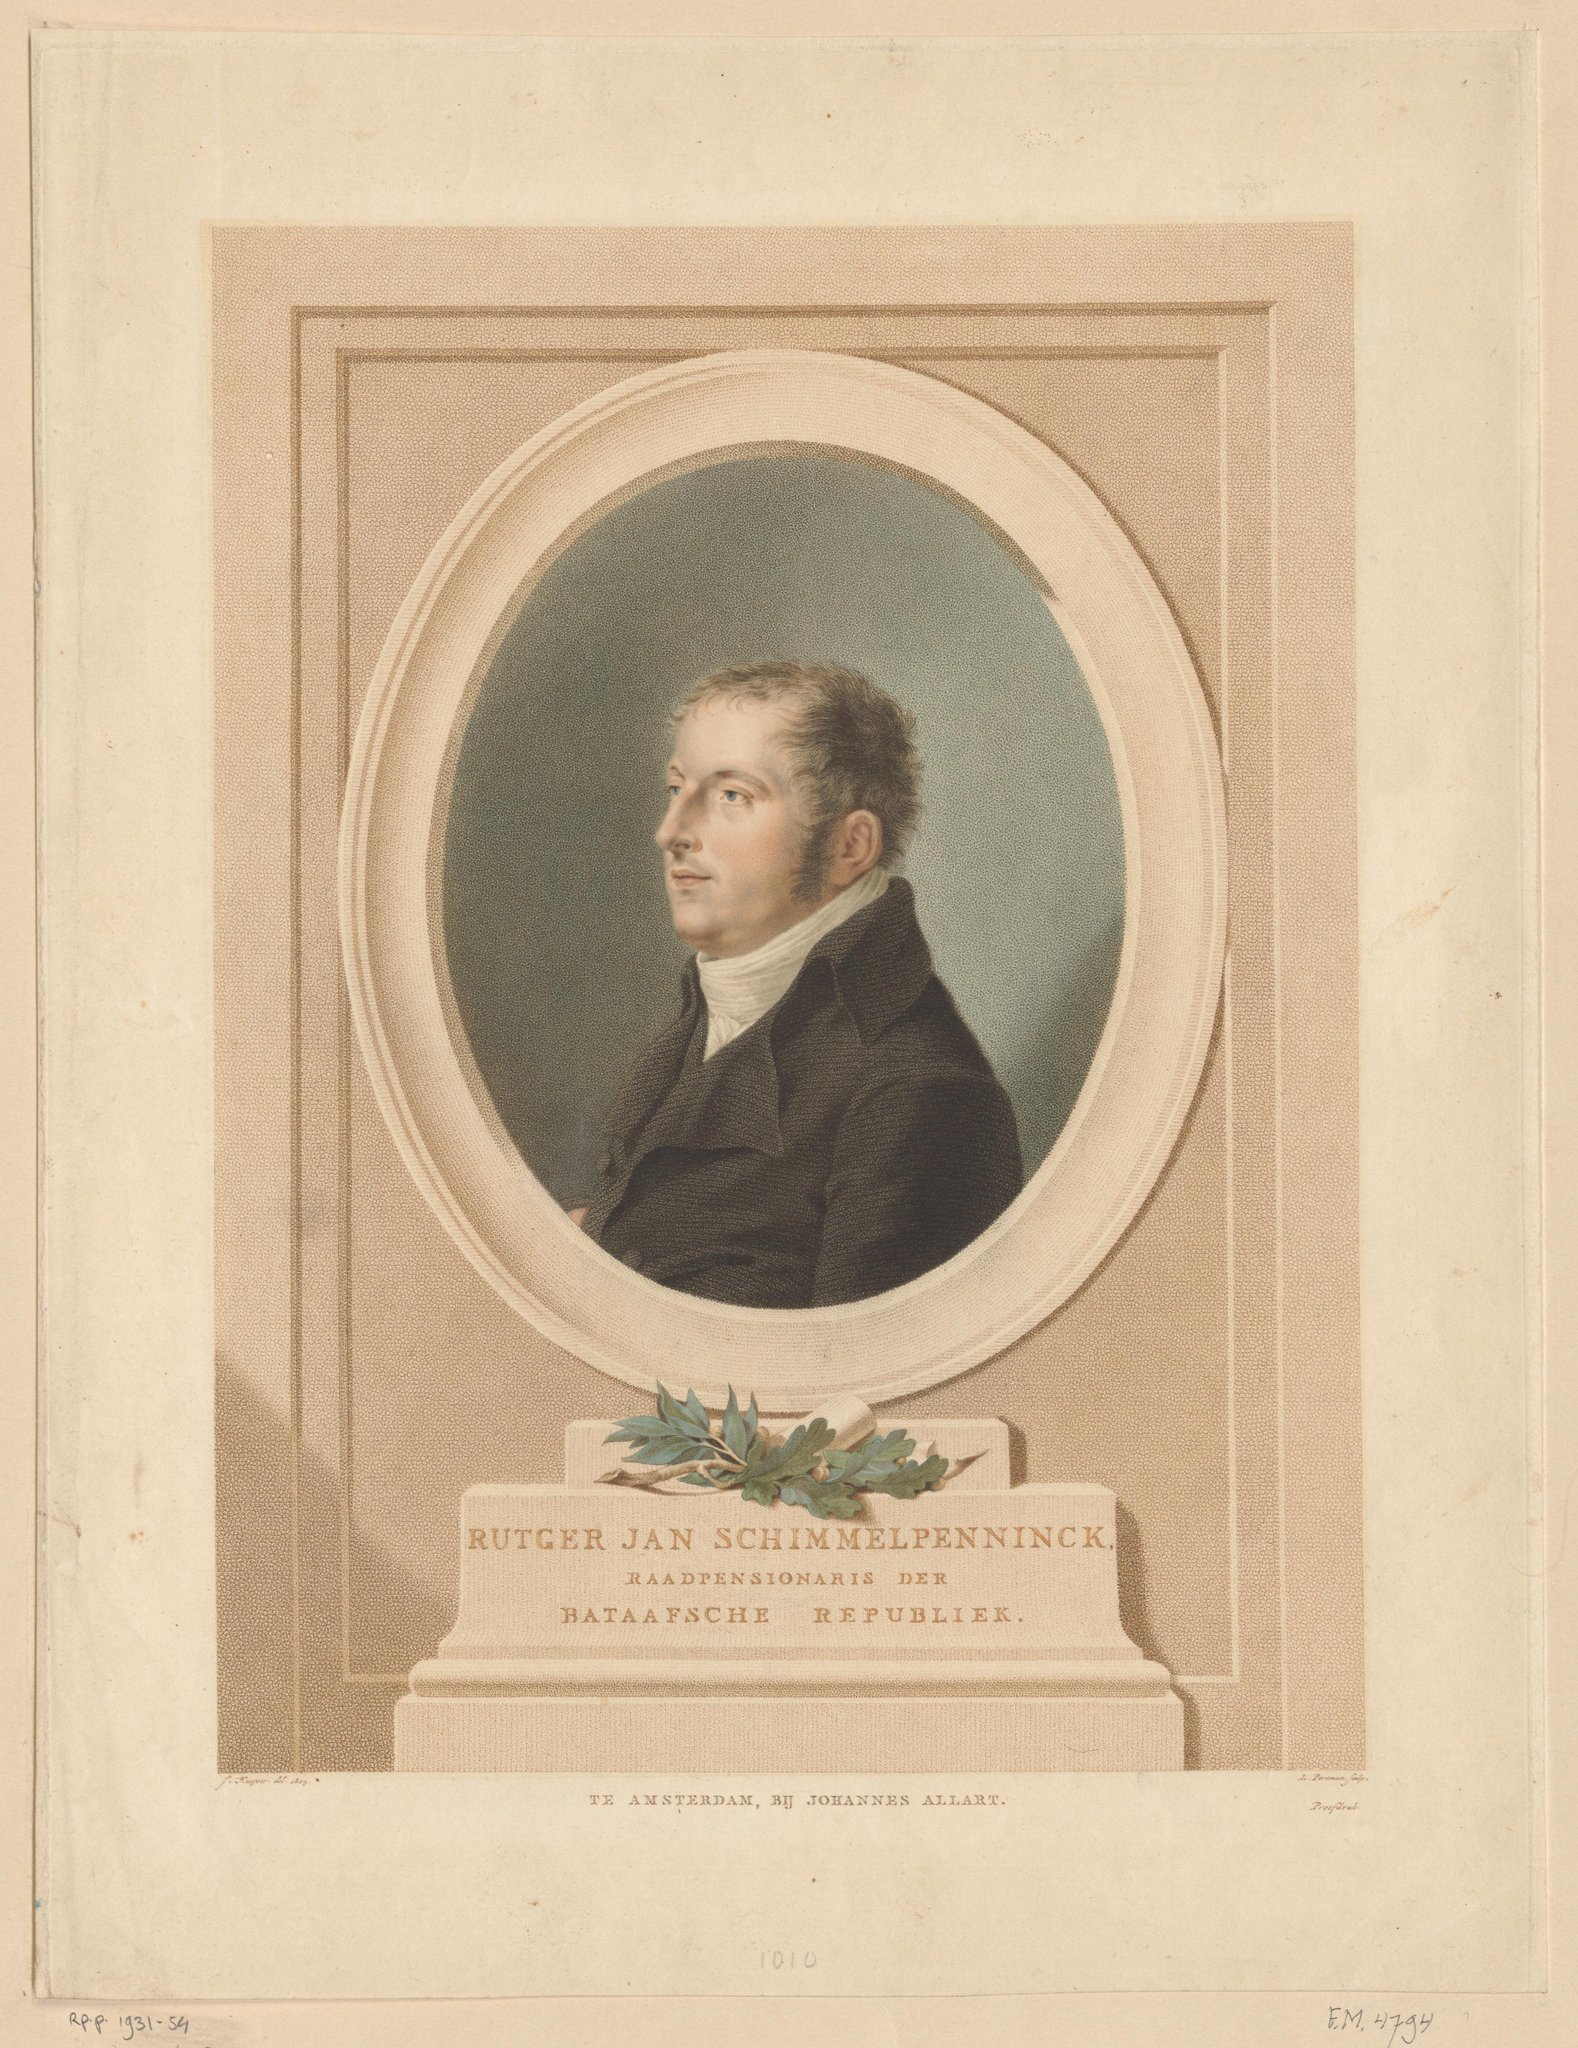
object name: print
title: Portret van Rutger Jan Schimmelpenninck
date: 1805-1817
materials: paper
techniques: printing, engraving, hand coloring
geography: amsterdam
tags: amsterdam, rutger jan schimmelpenninck (1761-1825), historical persons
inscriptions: collector's mark: Lugt 2228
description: Portret van Rutger Jan Schimmelpenninck, raadspensionaris van de Bataafse Republiek, in een ovaal. Onder het portret zijn naam en functie in drie regels in het Nederlands.